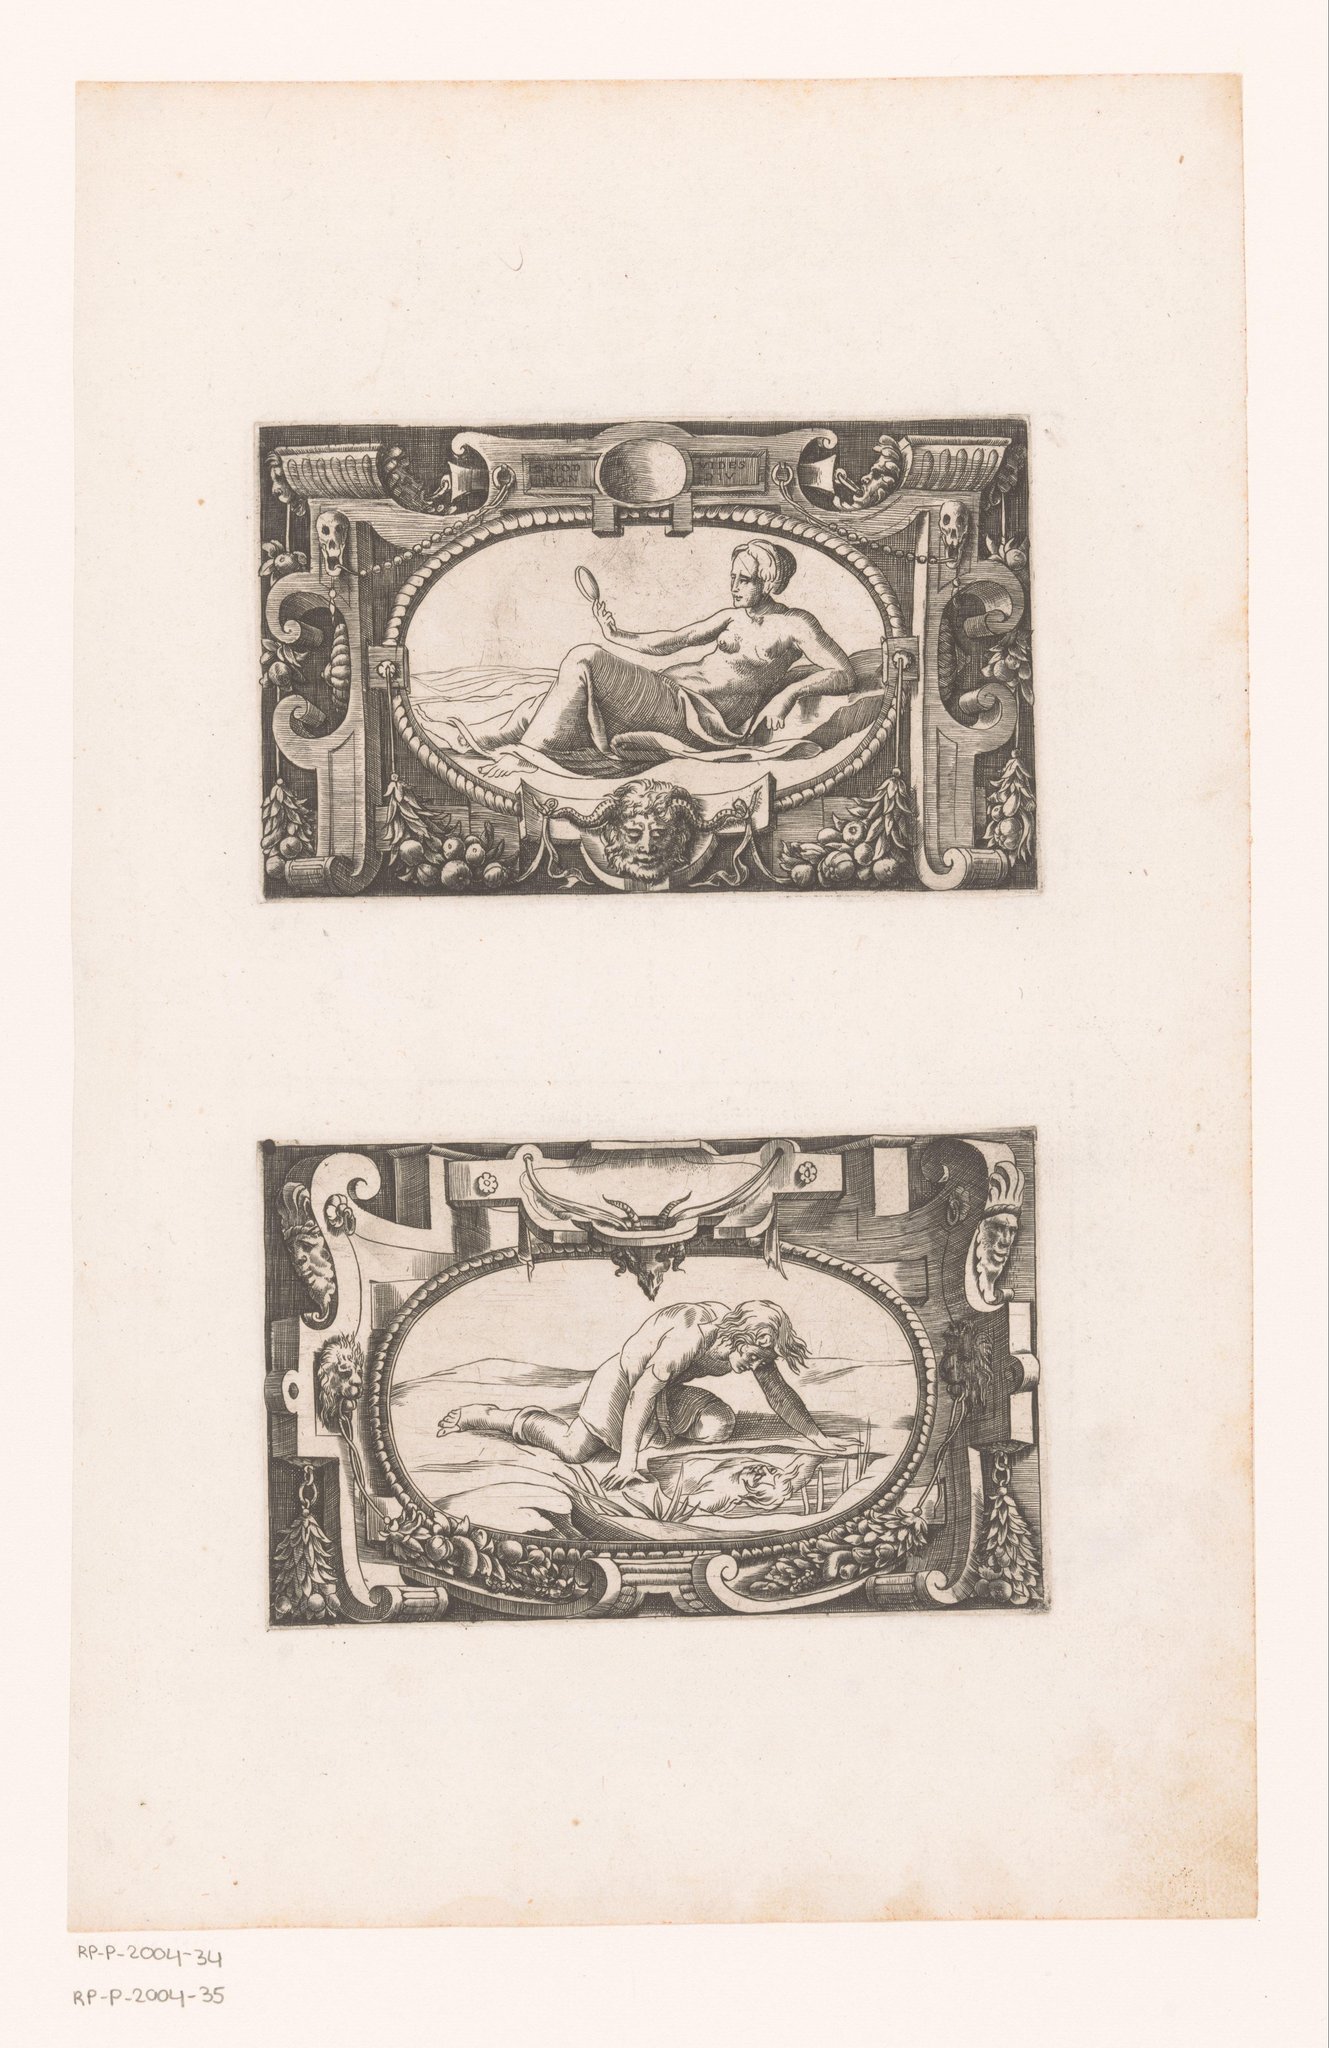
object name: print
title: Cartouches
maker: georges reverdy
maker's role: print maker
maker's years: 1450-1565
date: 1536-1569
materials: paper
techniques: engraving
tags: 'vanitas' symbols, ornament ~ cartouche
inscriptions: collector's mark: Lugt 2228, collector's mark: Lugt 2760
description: Prent maakt deel uit van een ongenummerde serie van drie prenten. Prent staat samen met RP-P-2004-35 op een onversneden blad.